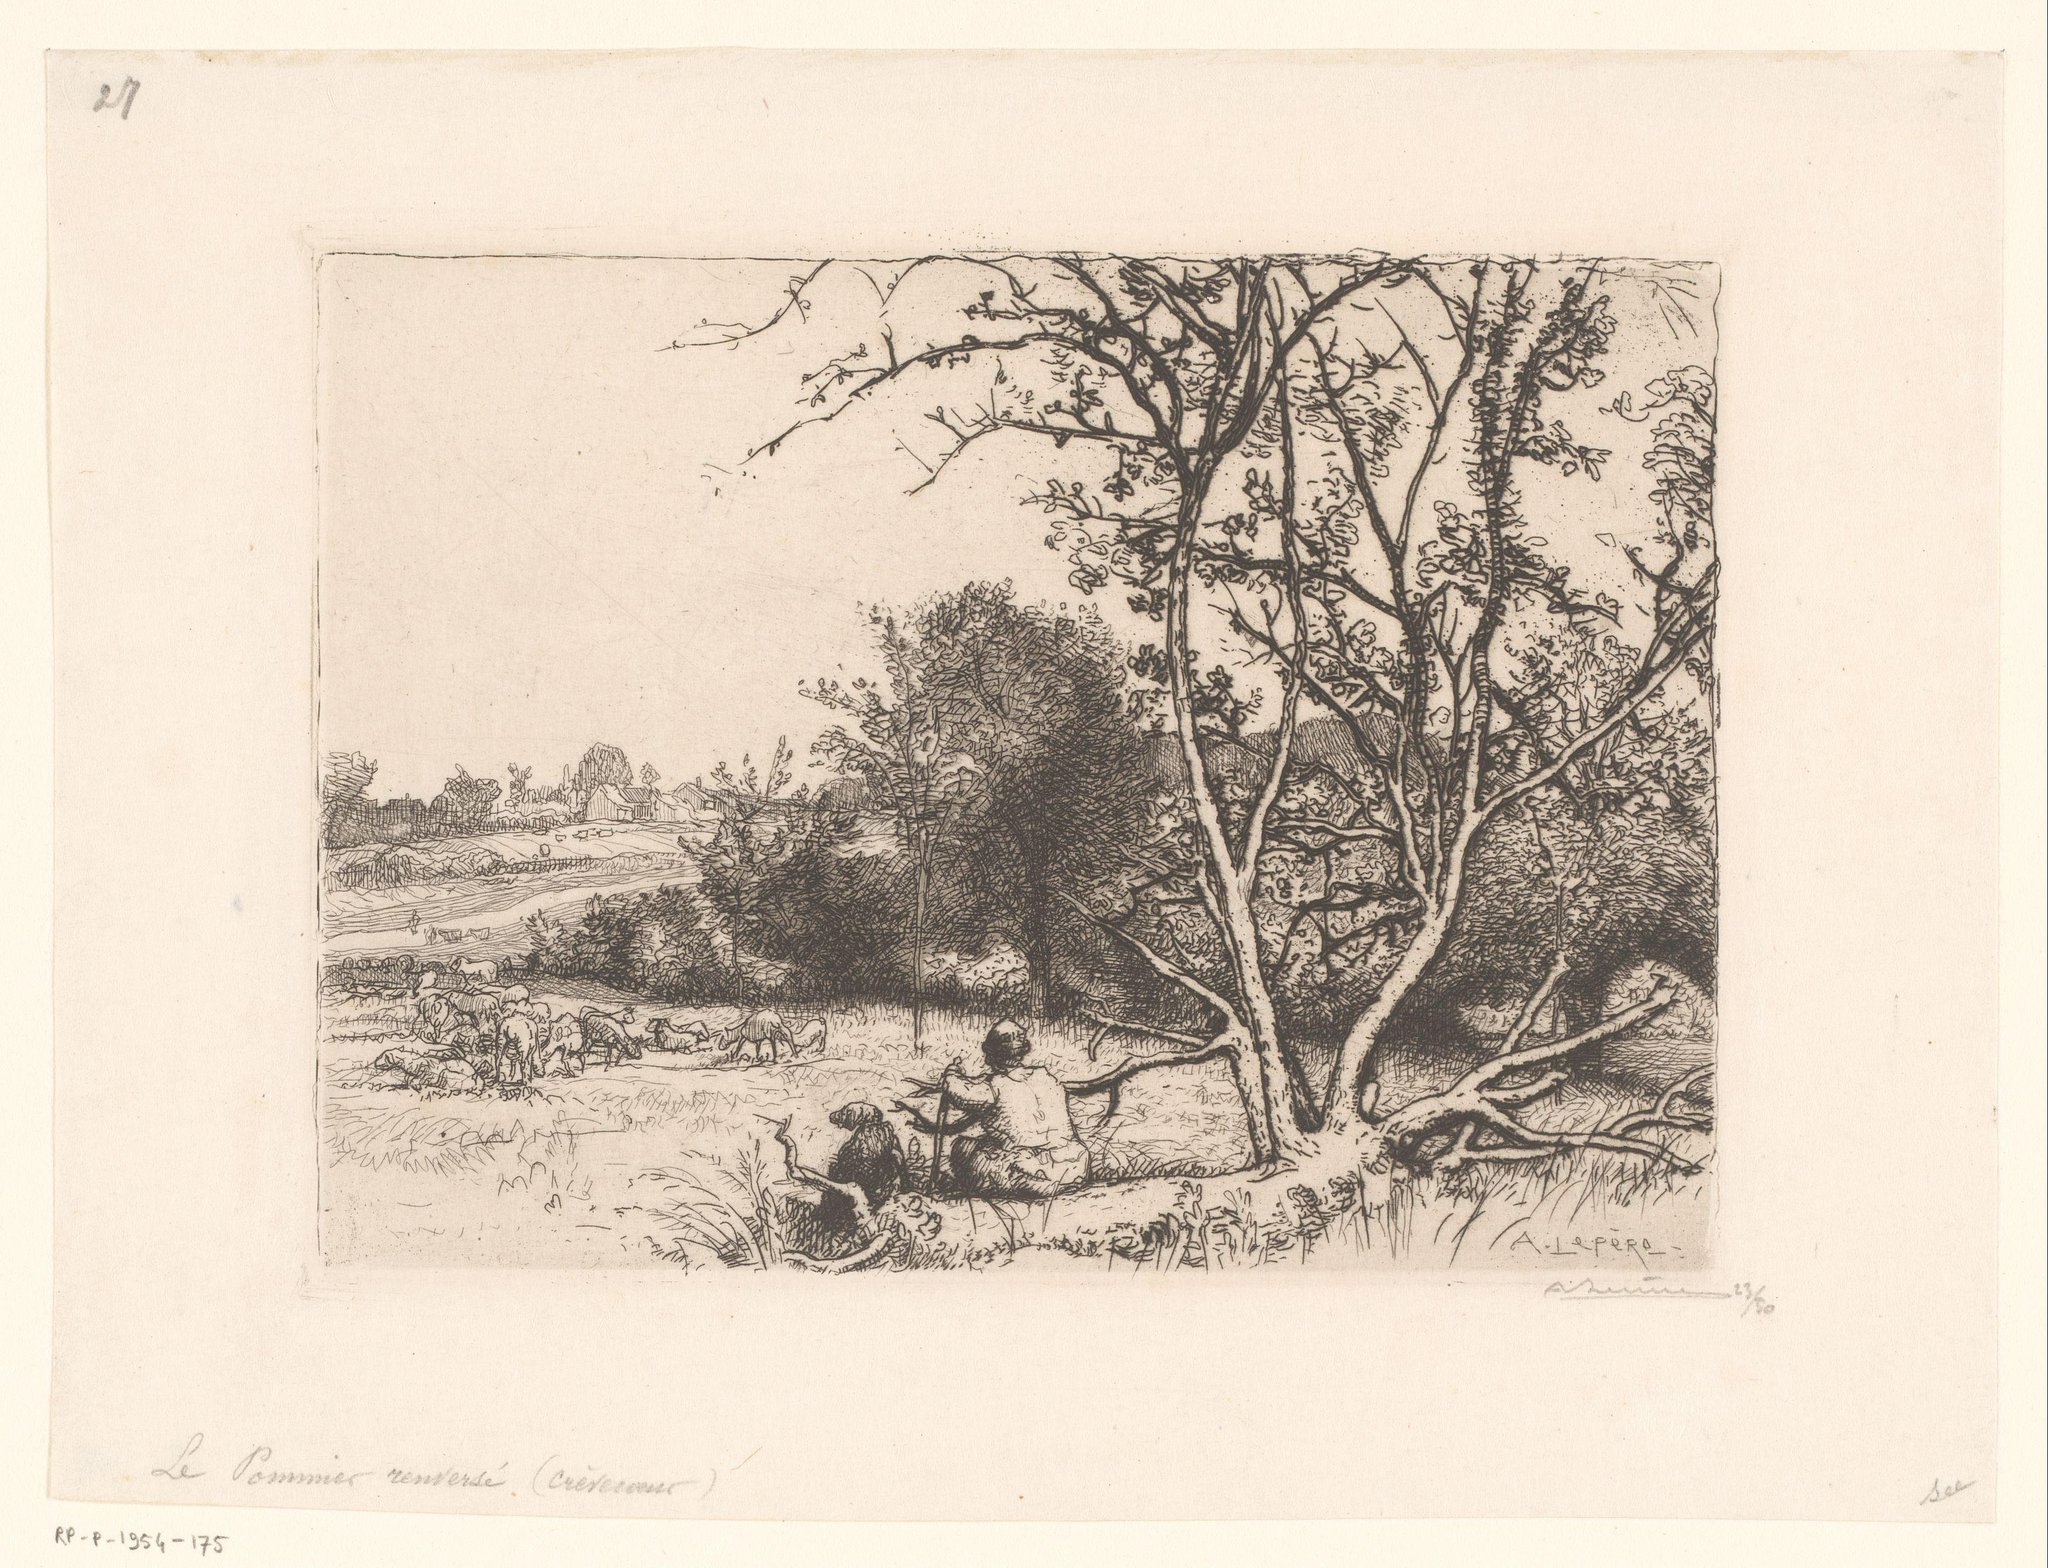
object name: print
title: Le pommier renversé (Crèvecoeur)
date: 1867-1917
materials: paper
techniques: drypoint, etching, intaglio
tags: trees (+ stem, trunk), herd, flock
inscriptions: check stamp: Lugt 2254, inscription: ‘Le pommier renversé (Crèvecoeur)’, collector's mark: Lugt 2760, collector's mark: Lugt 2228